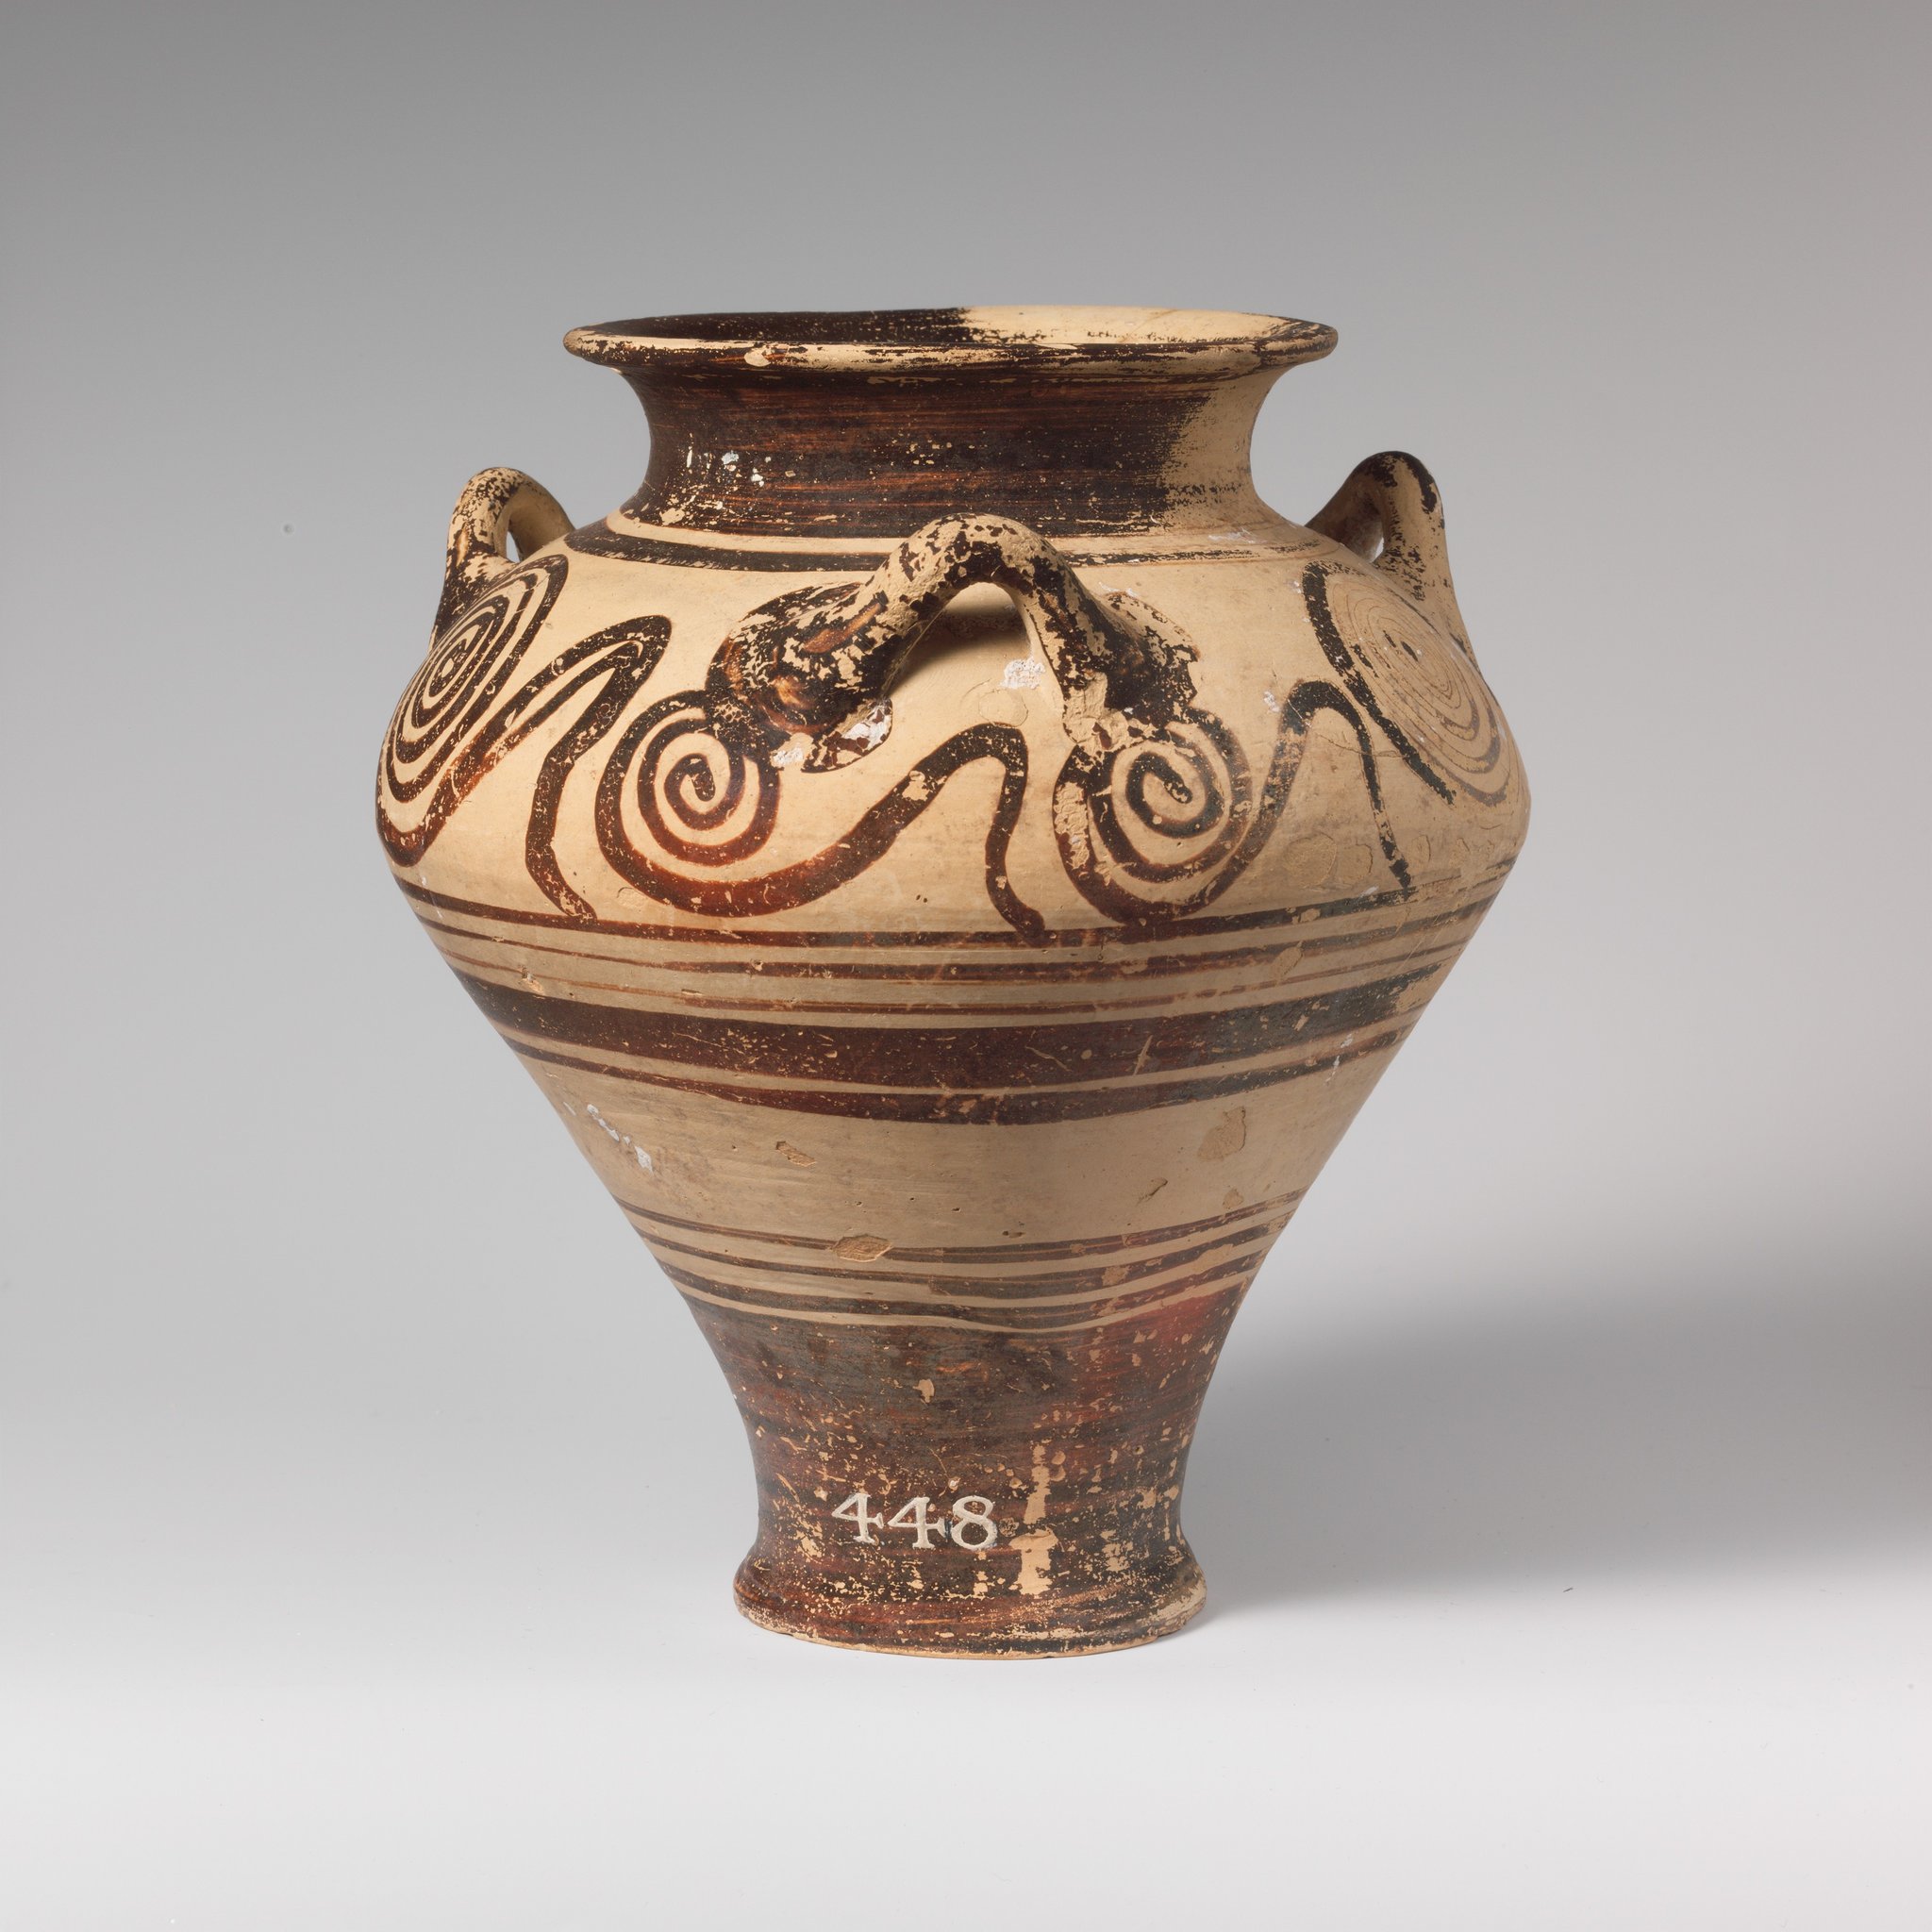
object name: pithoid jar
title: Terracotta pithoid jar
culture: mycenaean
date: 1375-1325 BCE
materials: terracotta